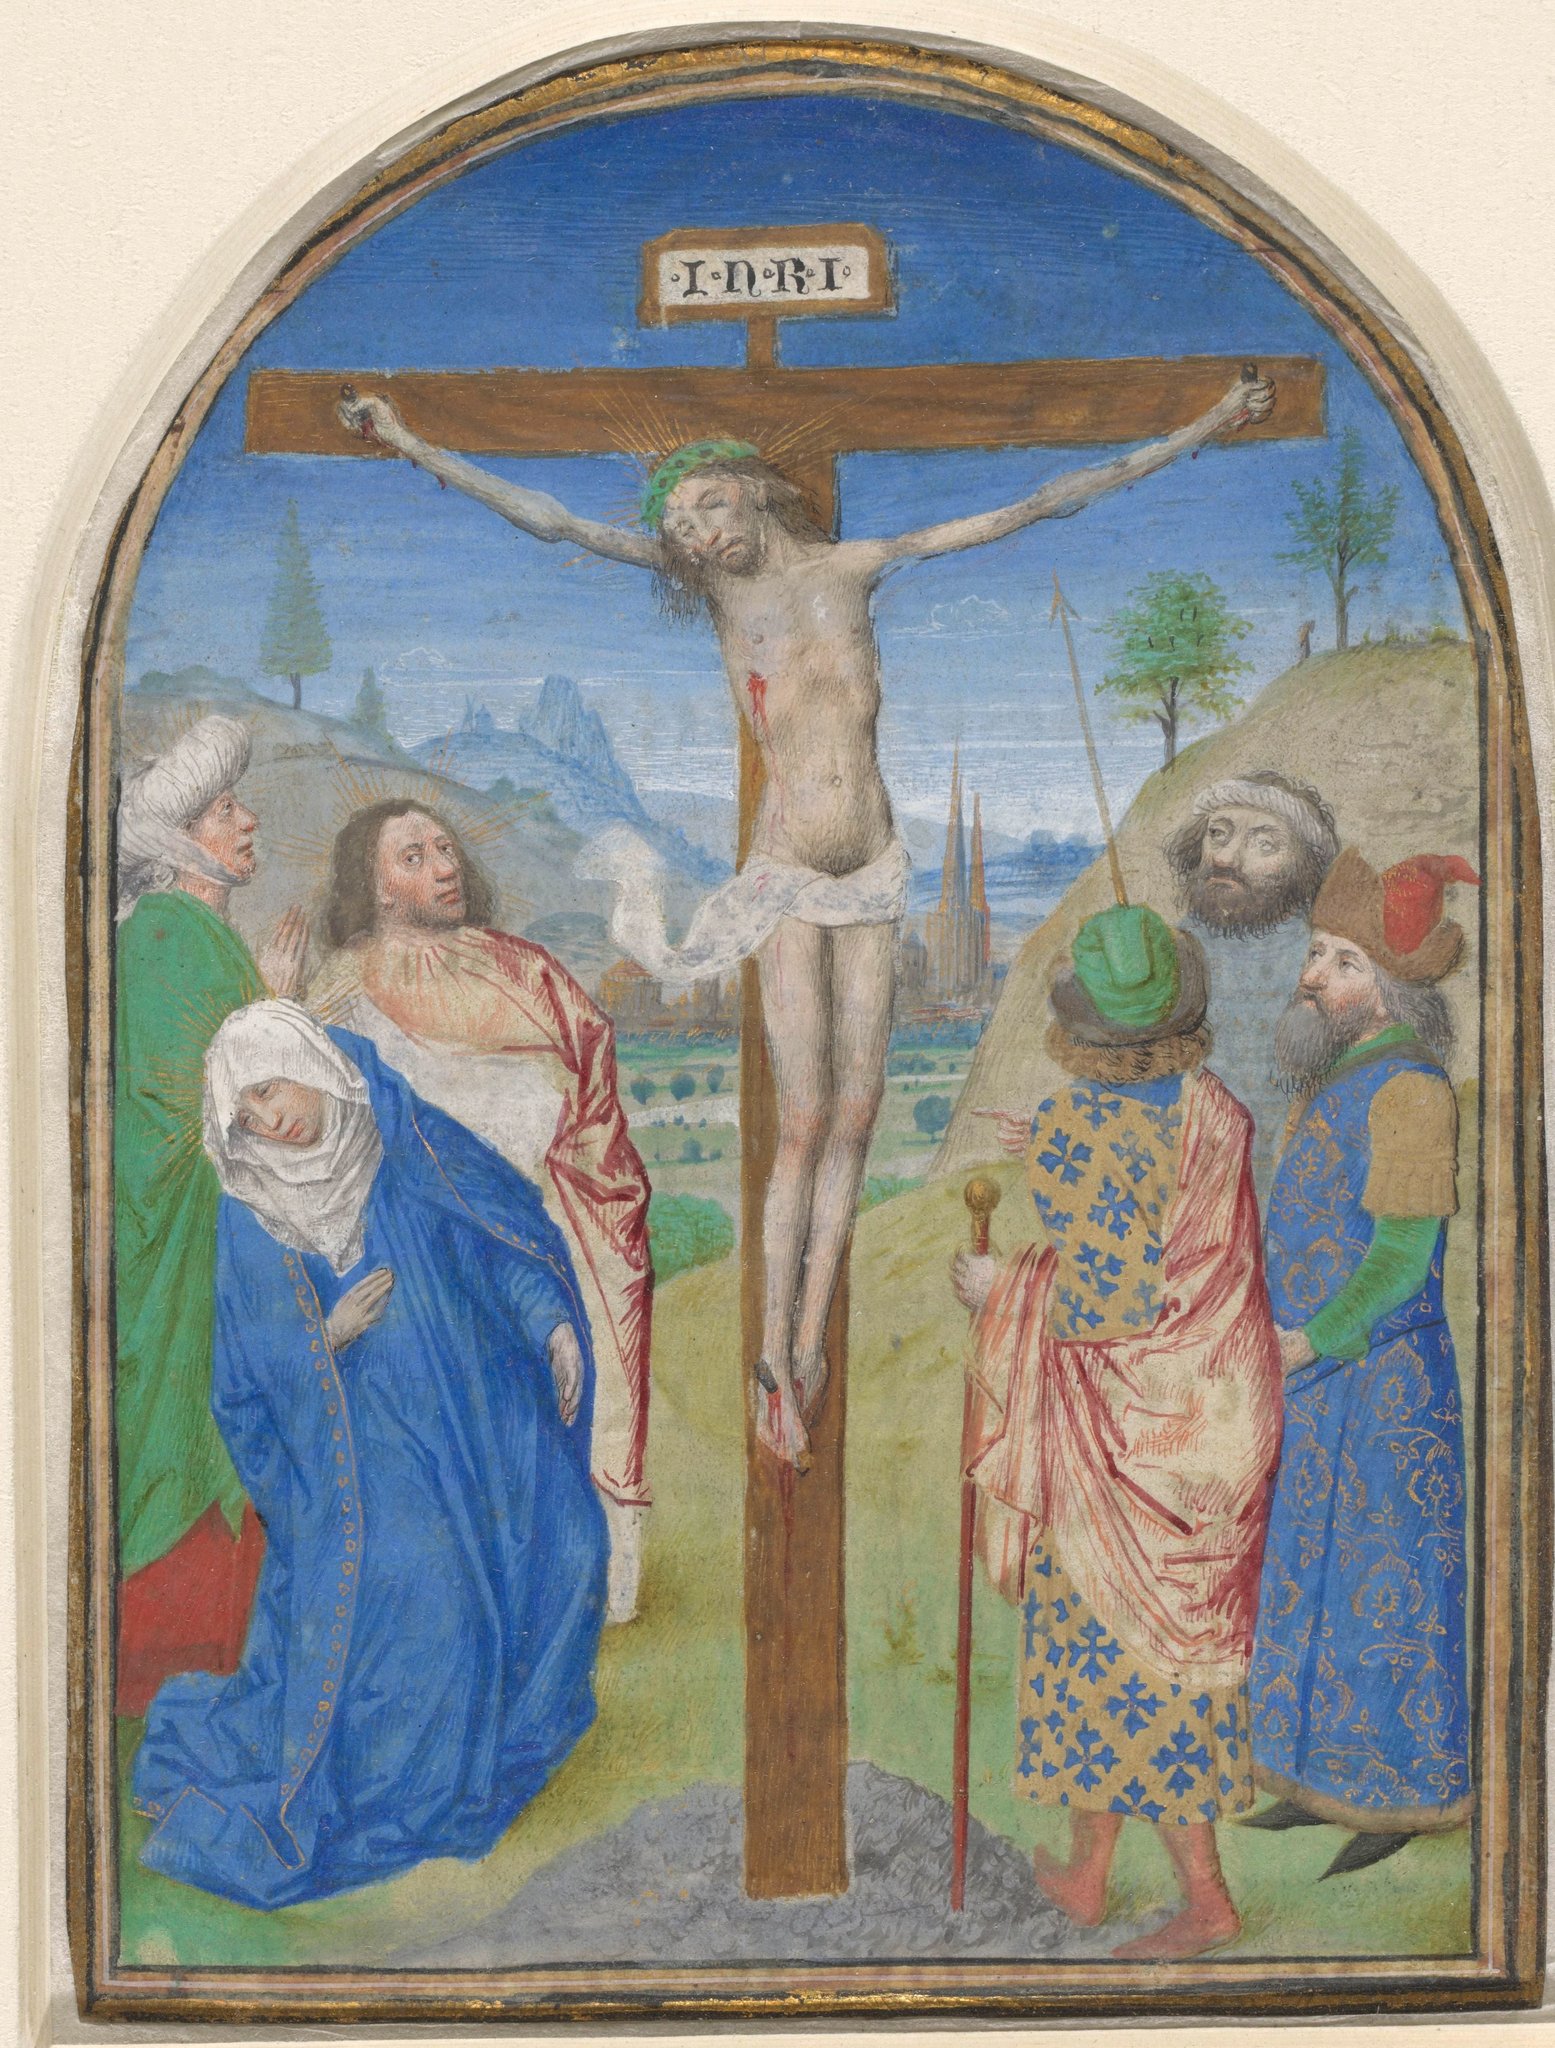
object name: illuminated manuscript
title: Christus aan het kruis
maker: simon marmion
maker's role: draughtsman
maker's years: 1420-1489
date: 1460-1470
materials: gouache, parchment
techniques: brush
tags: crucified christ, with particular persons under the cross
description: los blad uit een Noord-Frans getijdenboek met 12 resterende miniaturen; de overige 8 bevinden zich in de British Library